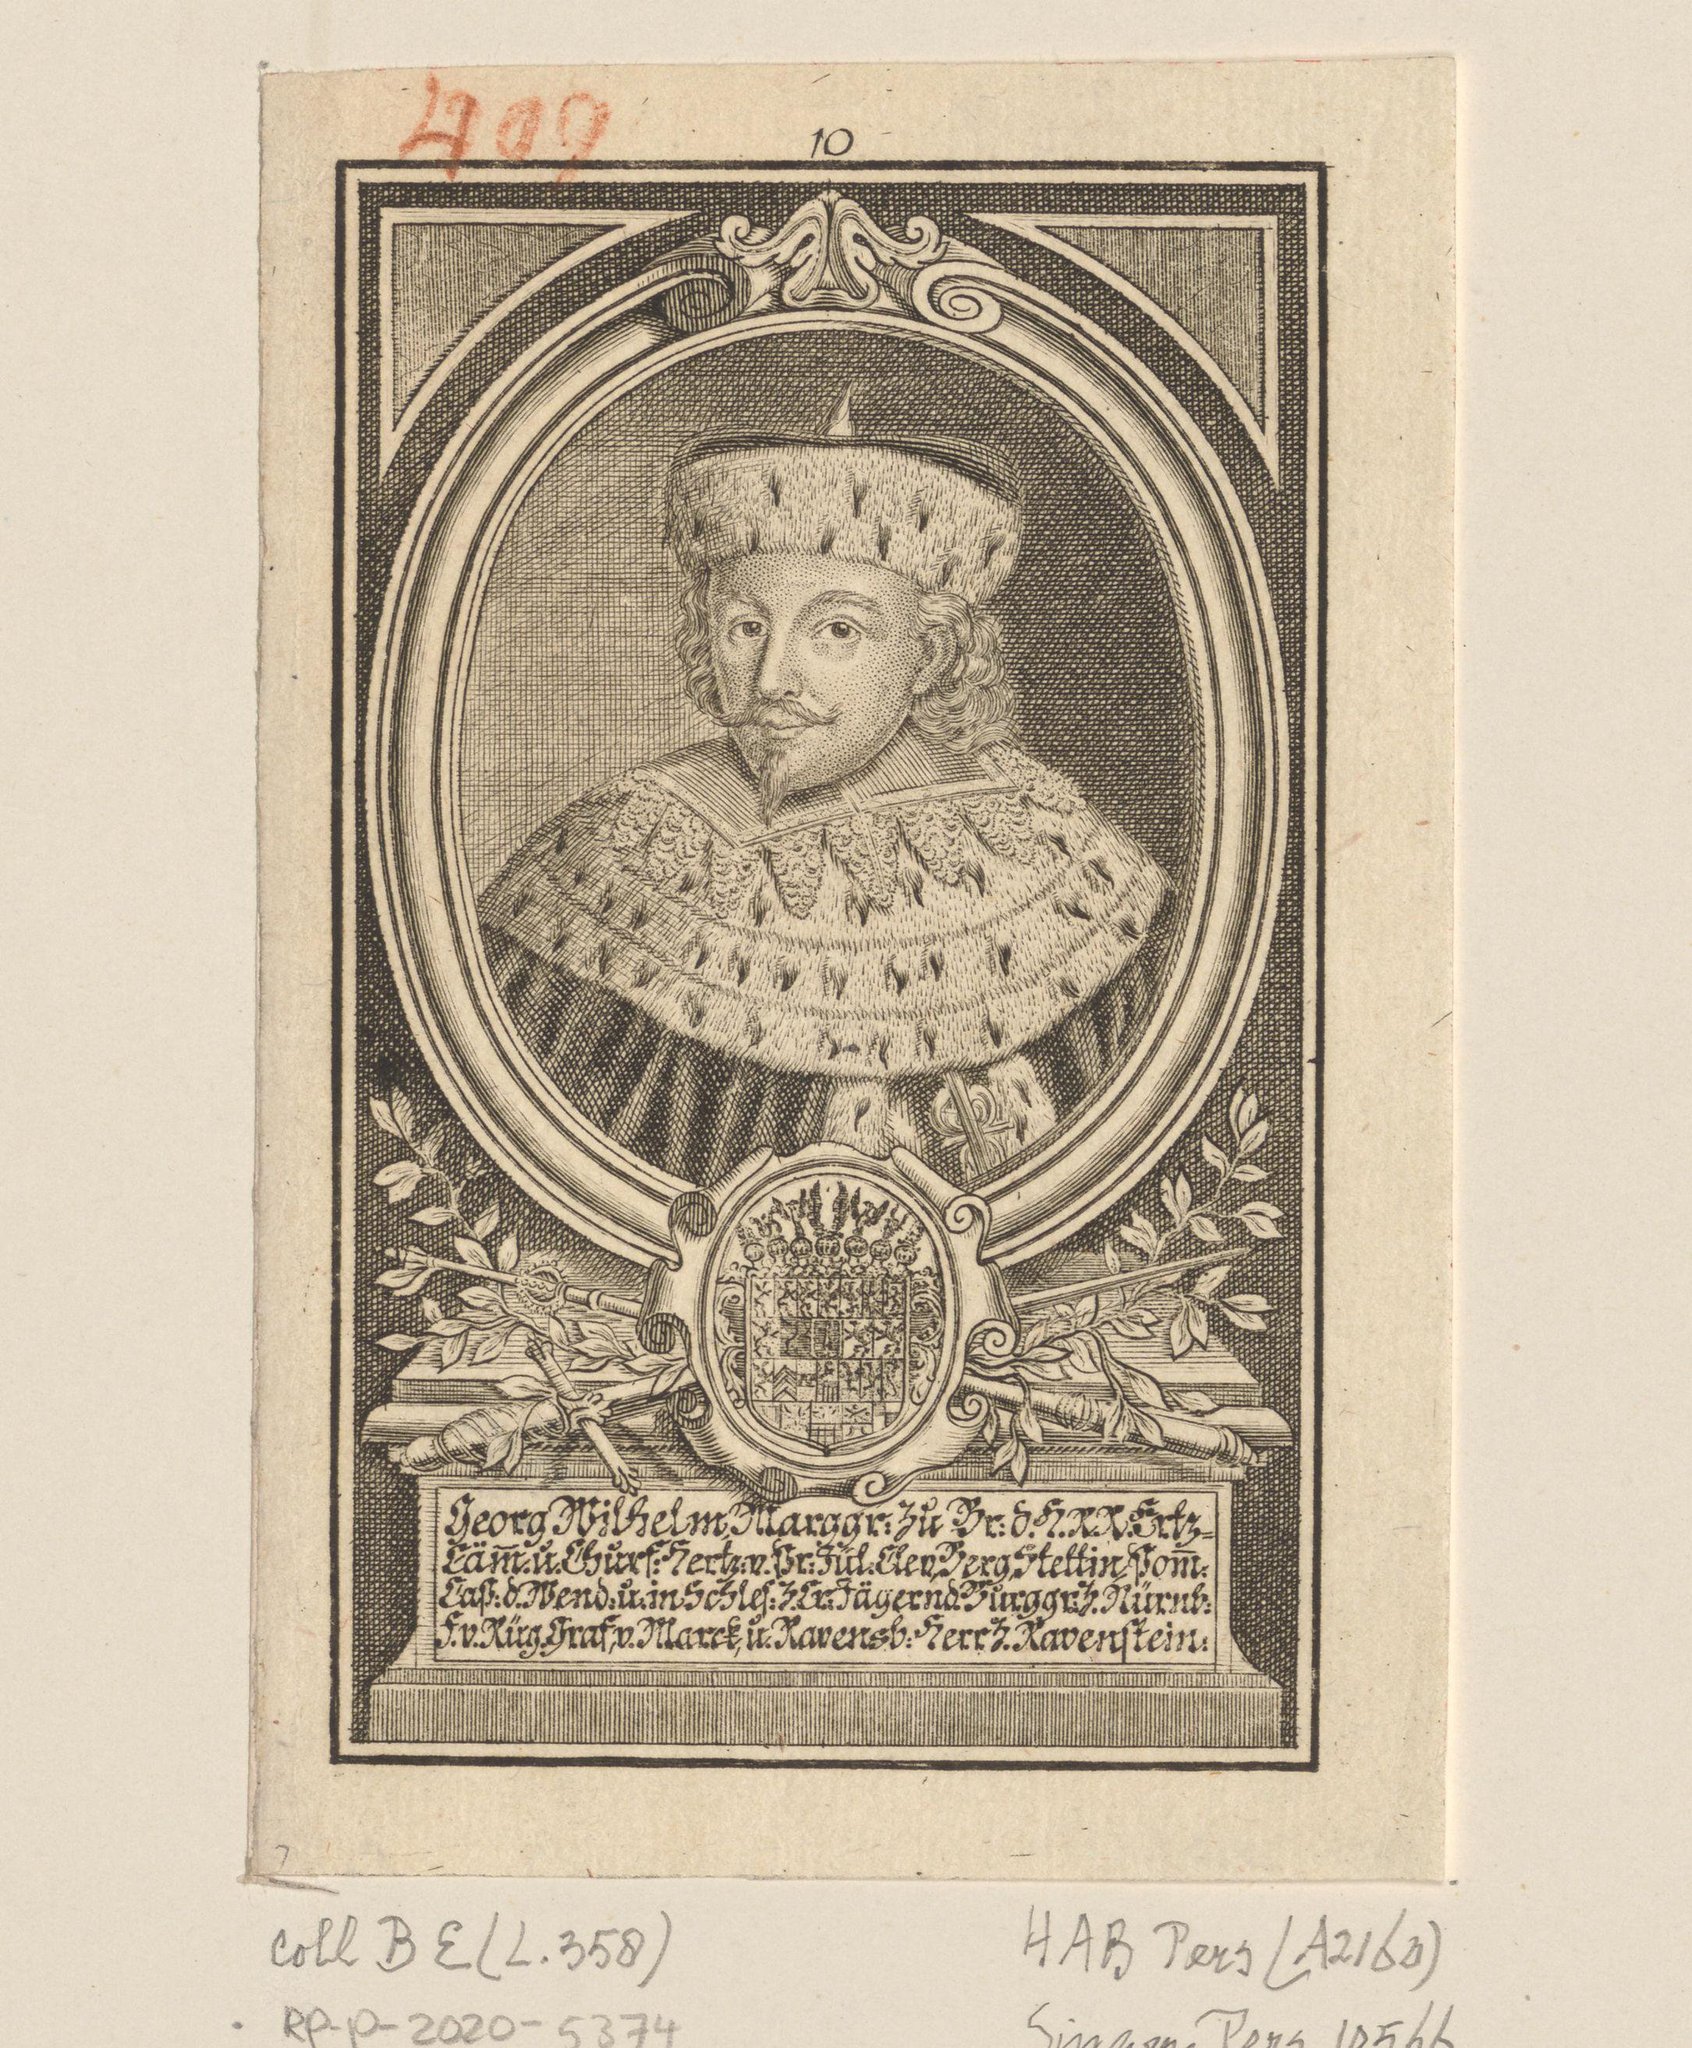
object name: print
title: Portret van Georg Wilhelm van Brandenburg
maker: Anonymous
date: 1610-1640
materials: paper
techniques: engraving, etching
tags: cologne, historical persons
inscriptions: collector's mark: Lugt 358, number: ‘409’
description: Tekst in het Duits in de ondermarge. Genummerd: 10.